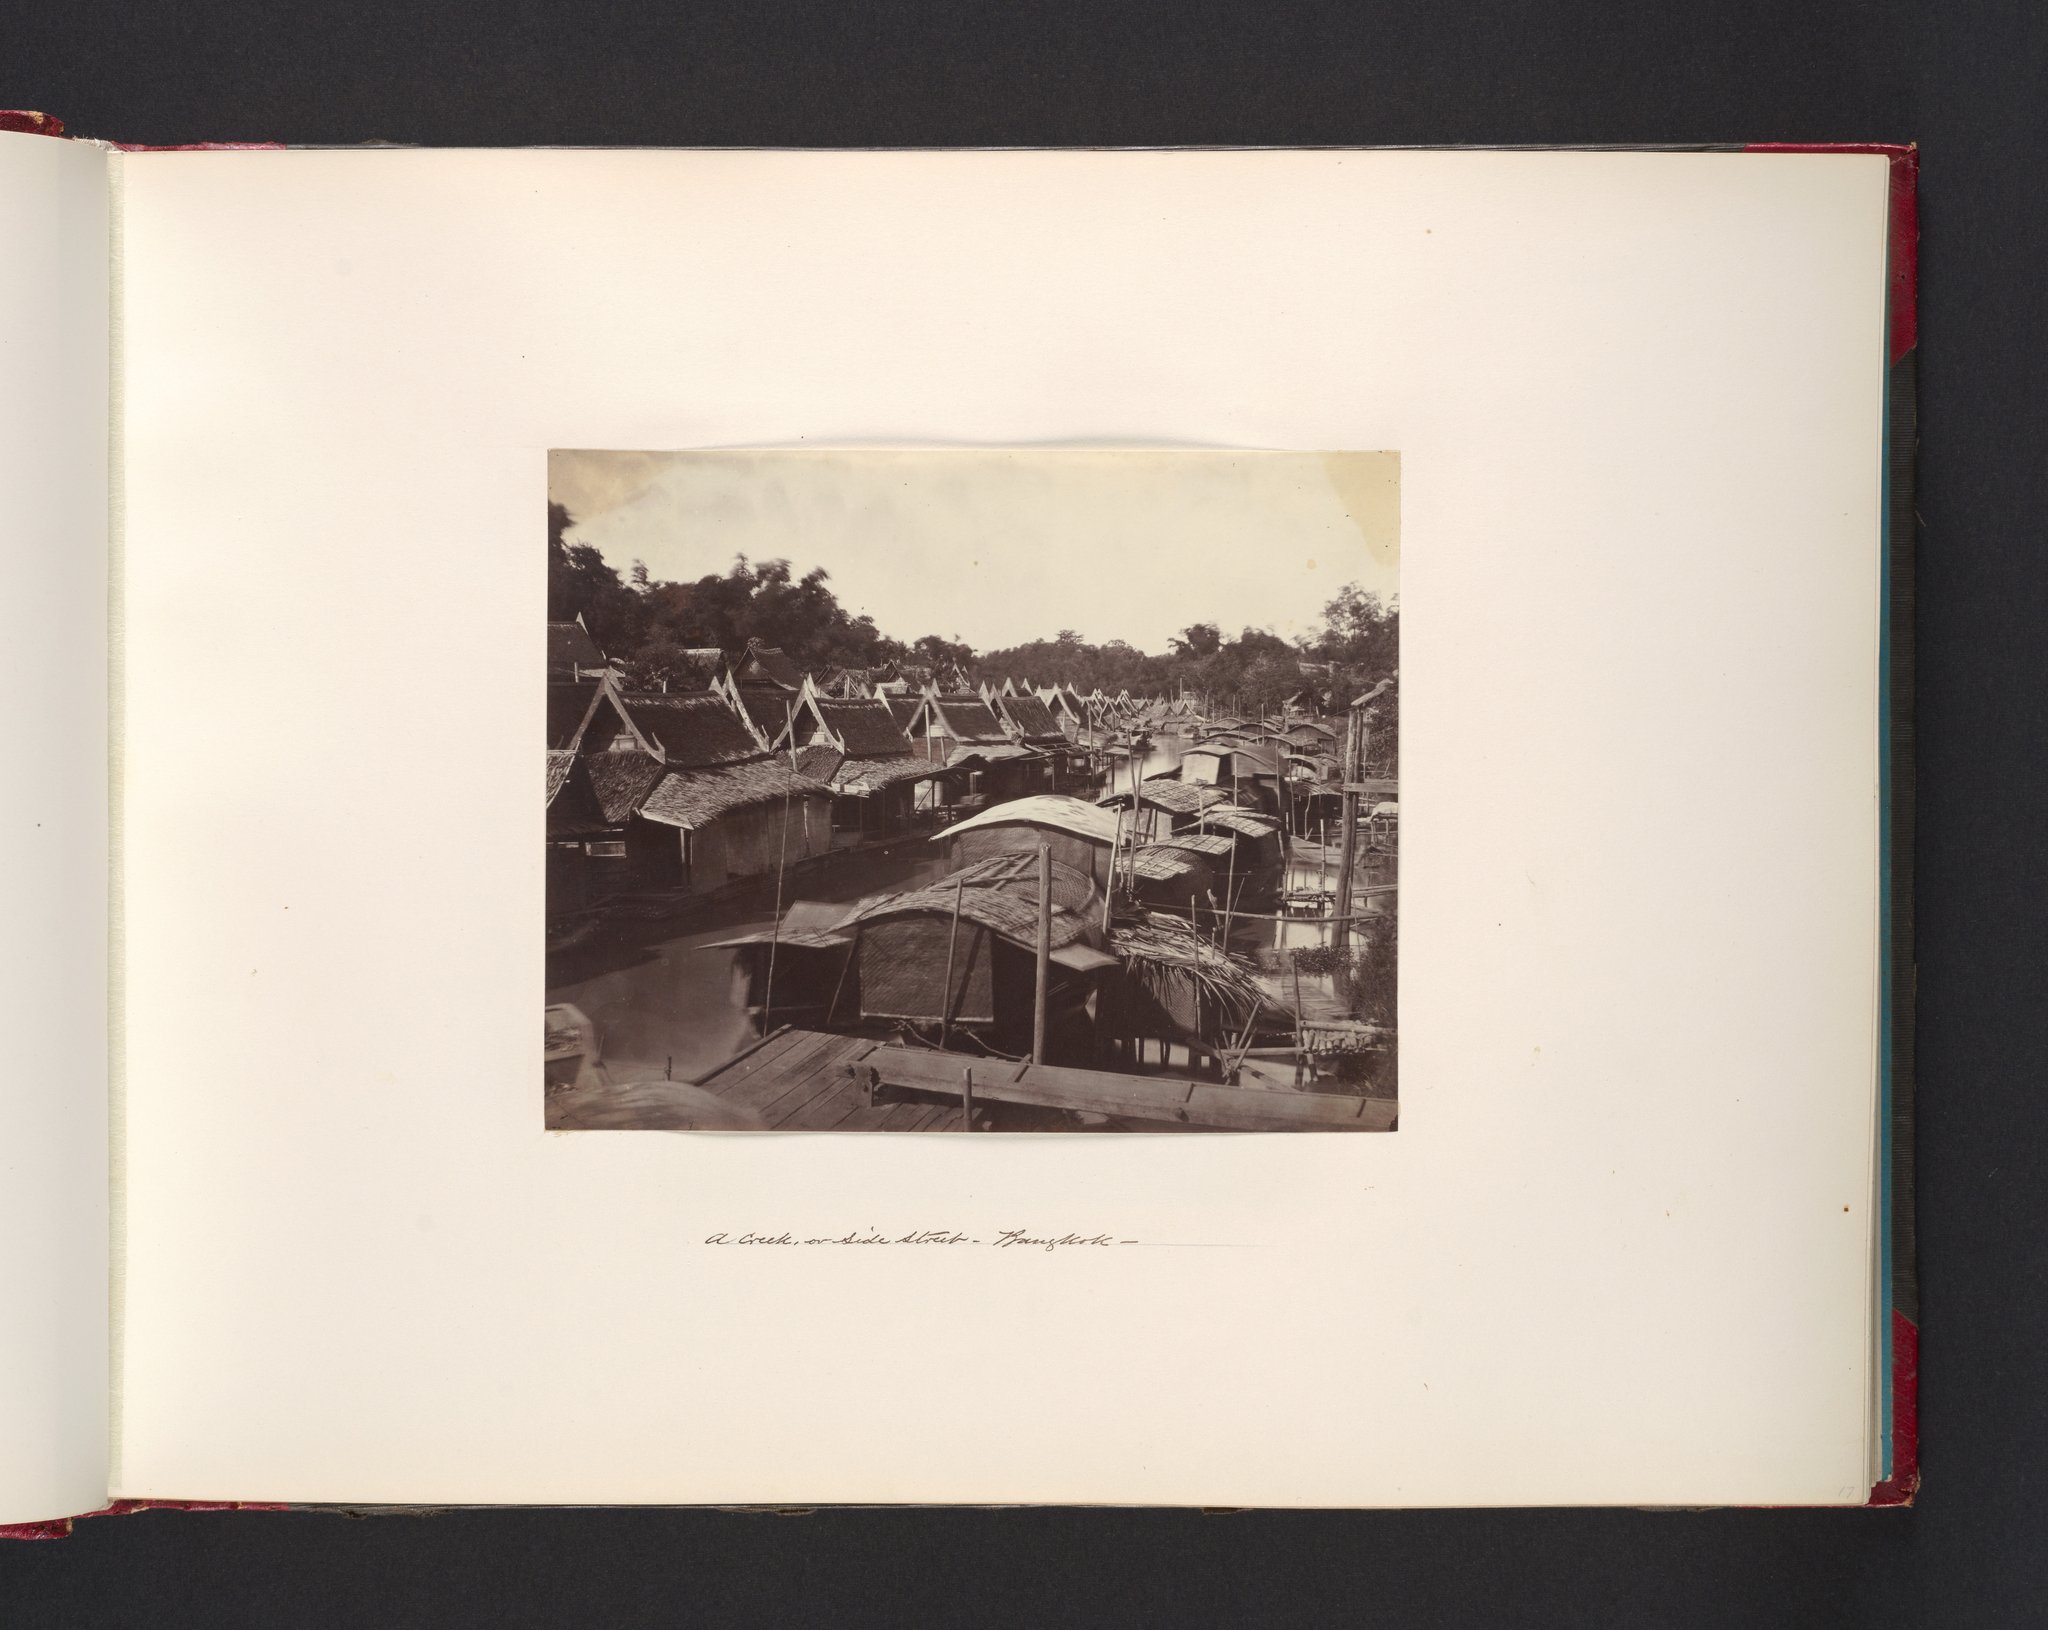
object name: photograph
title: A Creek, or Side Street, Hong Kong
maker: john thomson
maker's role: artist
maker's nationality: british, scottish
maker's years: 1837-1921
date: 1865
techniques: albumen silver print, glass negative